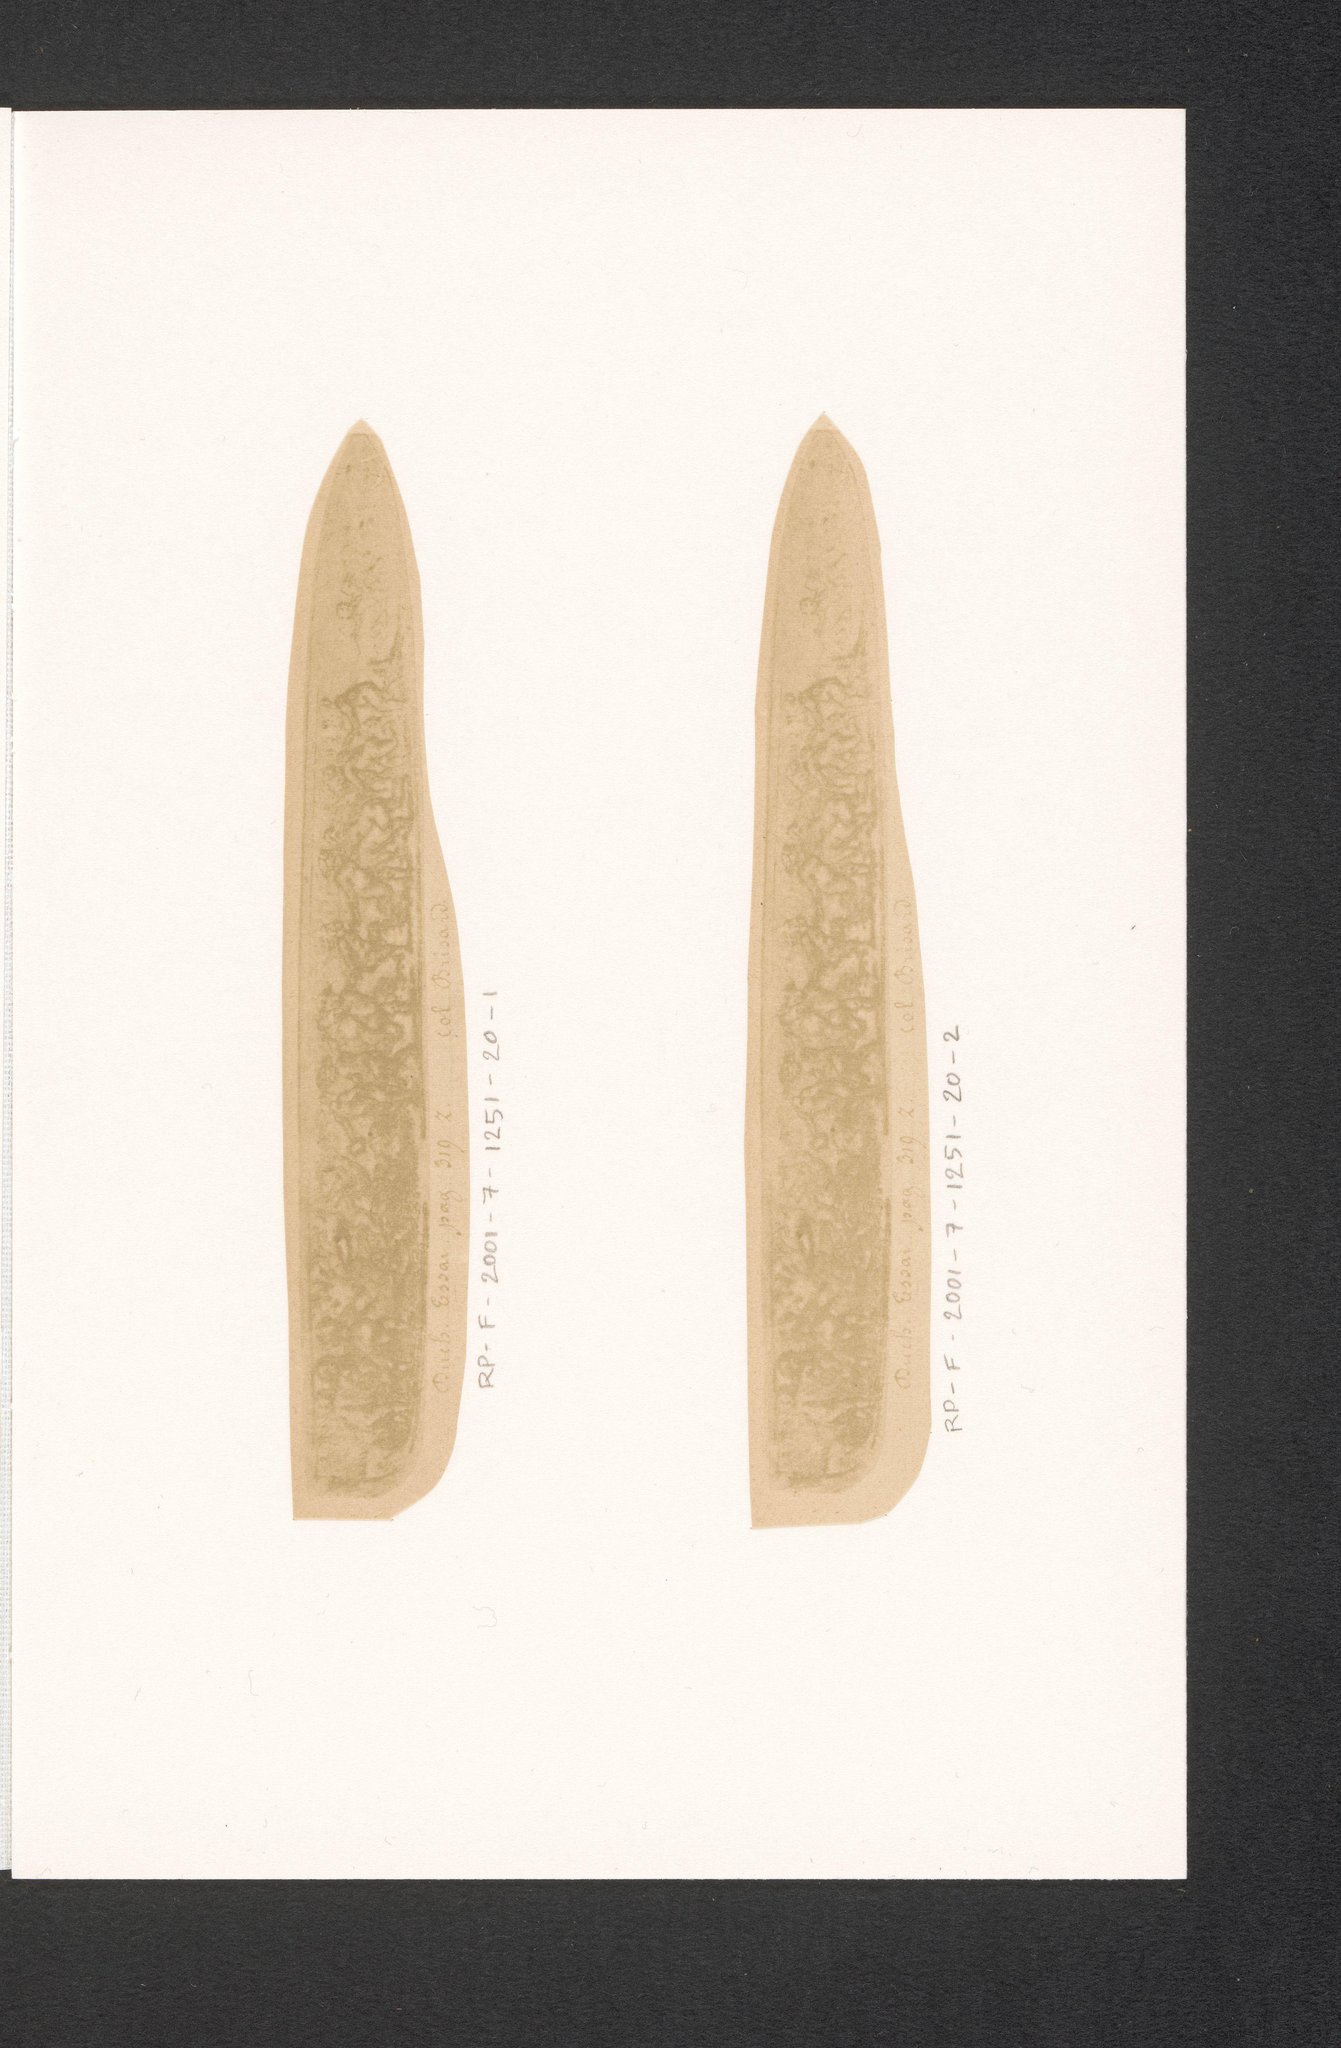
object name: page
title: Fotoreproductie van een prent van een kinderbacchanaal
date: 1852-1857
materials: photographic support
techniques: salted paper print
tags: children's bacchanal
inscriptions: inscription: ‘Duch. Essai pag 319. Z. col. Bisard’